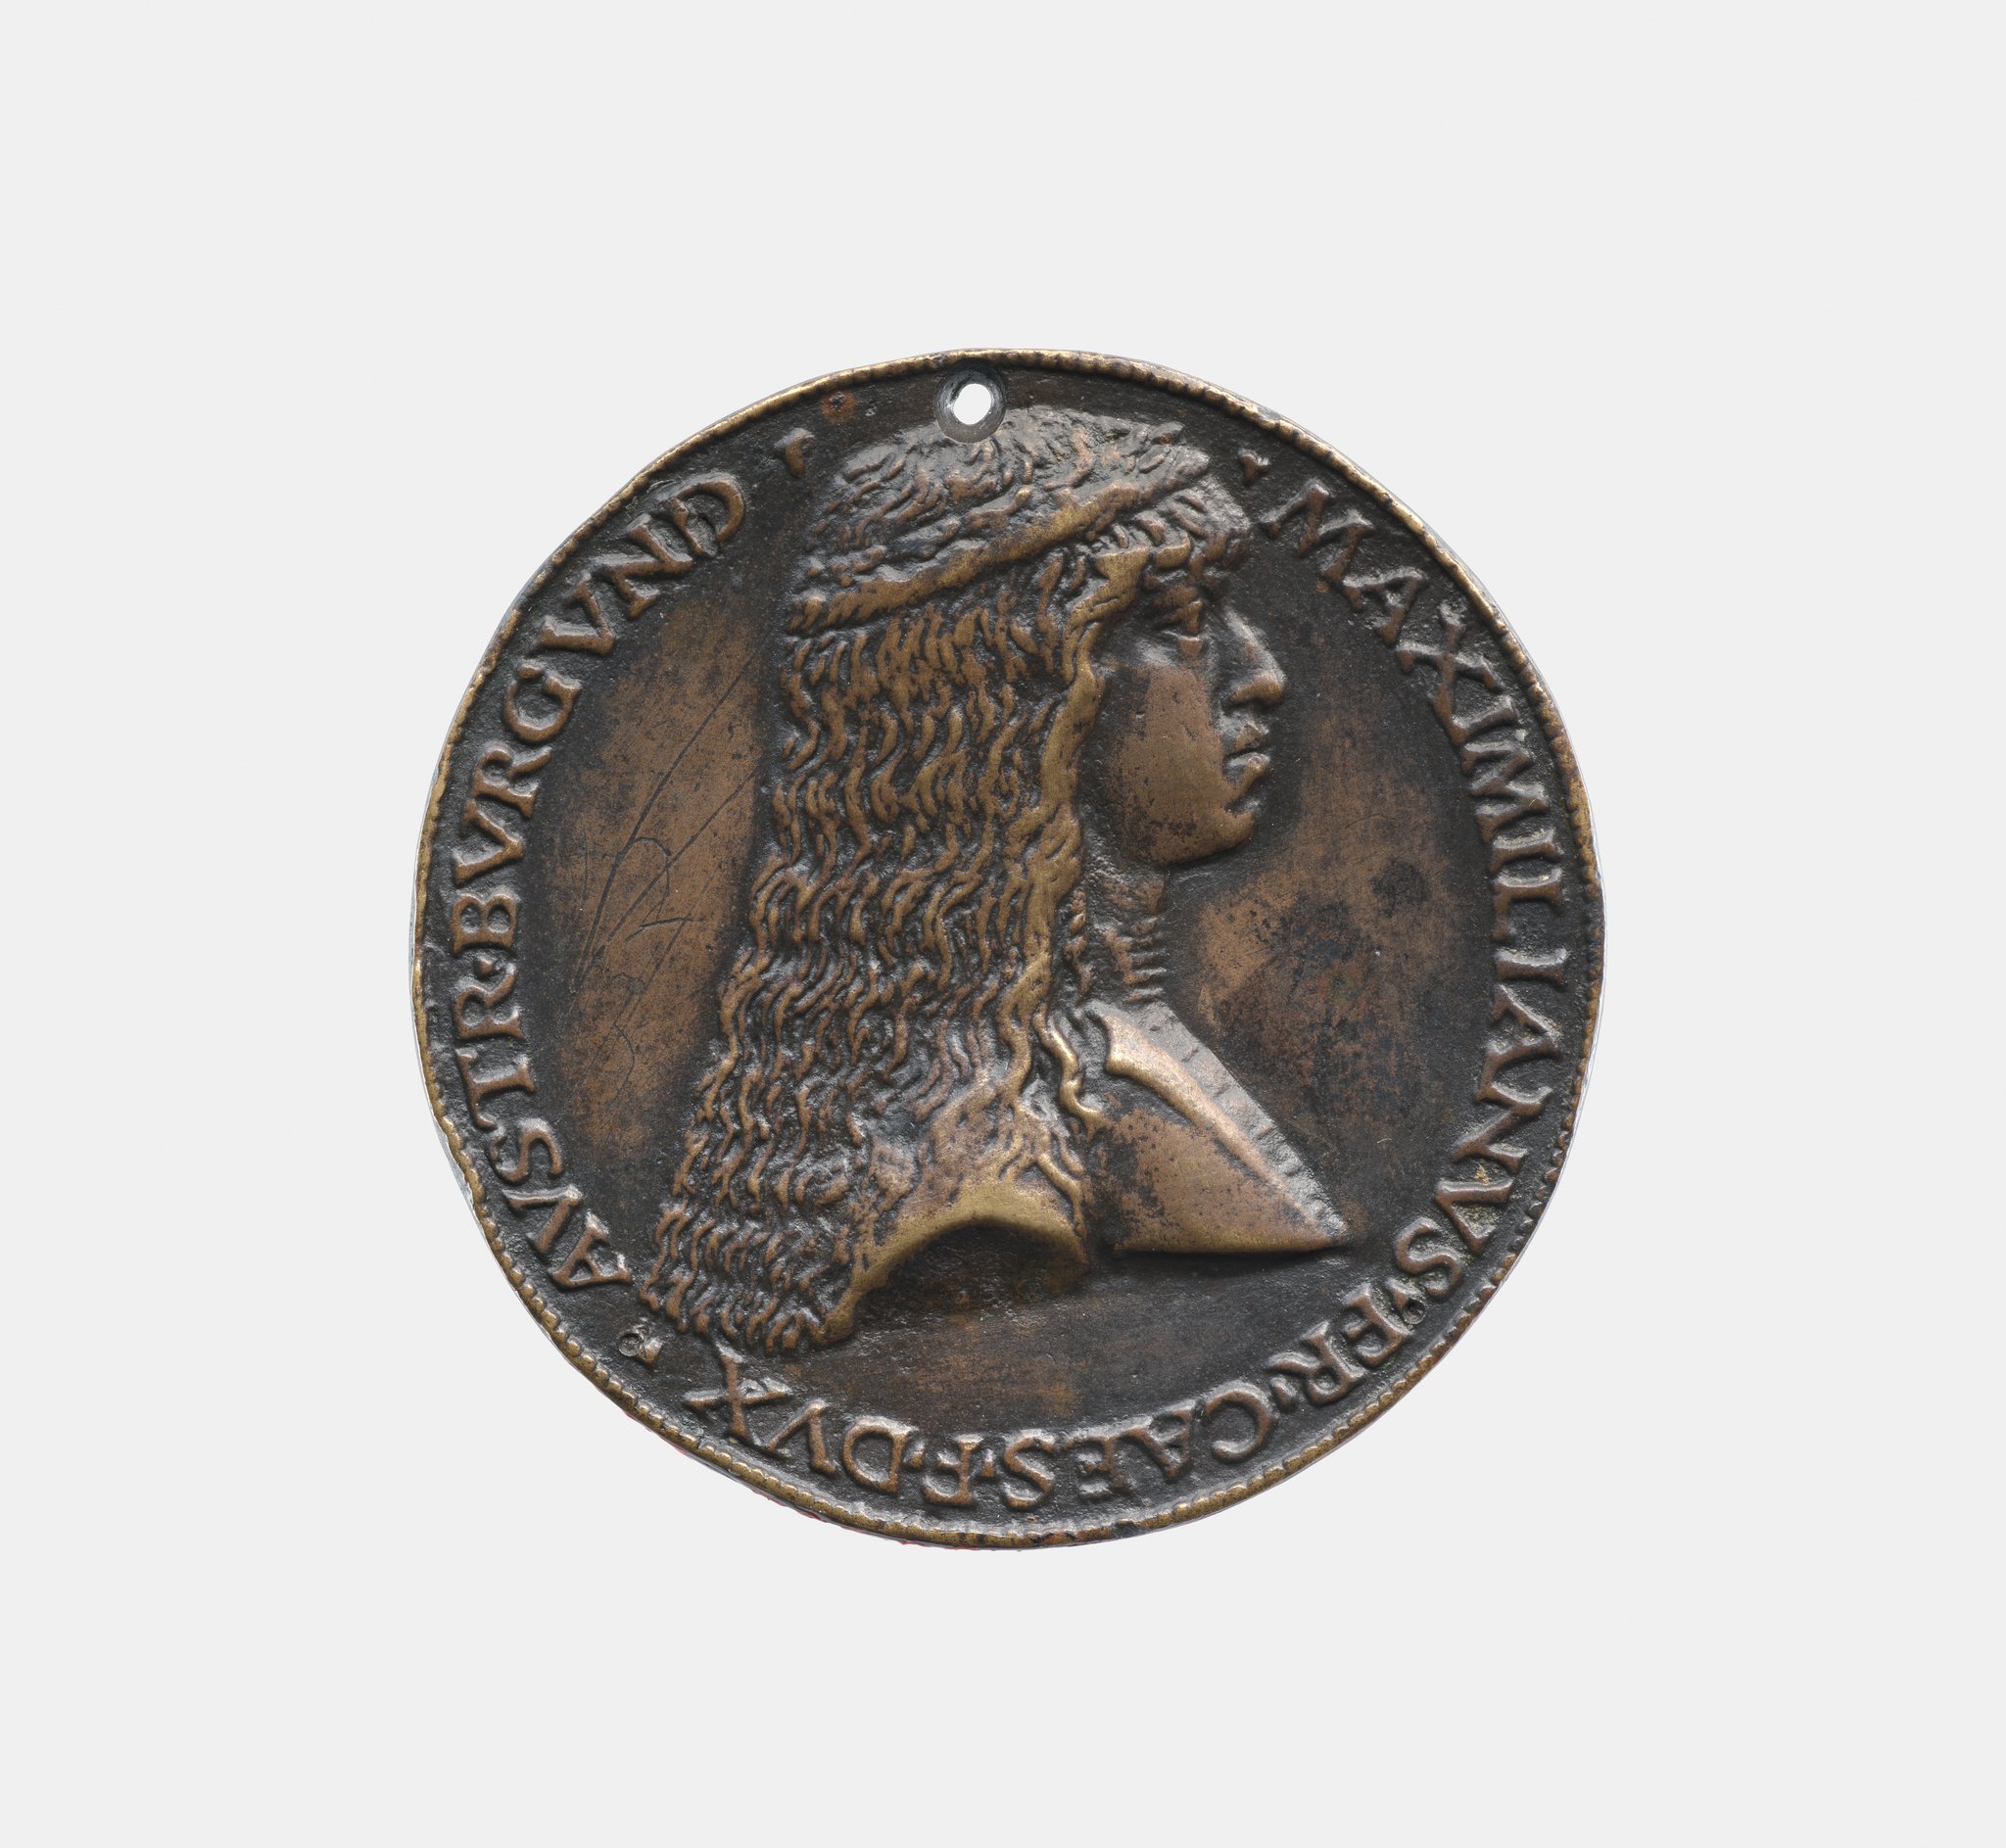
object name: medal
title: Marriage of Maximilian I of Austria and Mary of Burgundy, 1477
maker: giovanni filangieri candida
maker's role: artist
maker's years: 1450-1504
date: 1477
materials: bronze